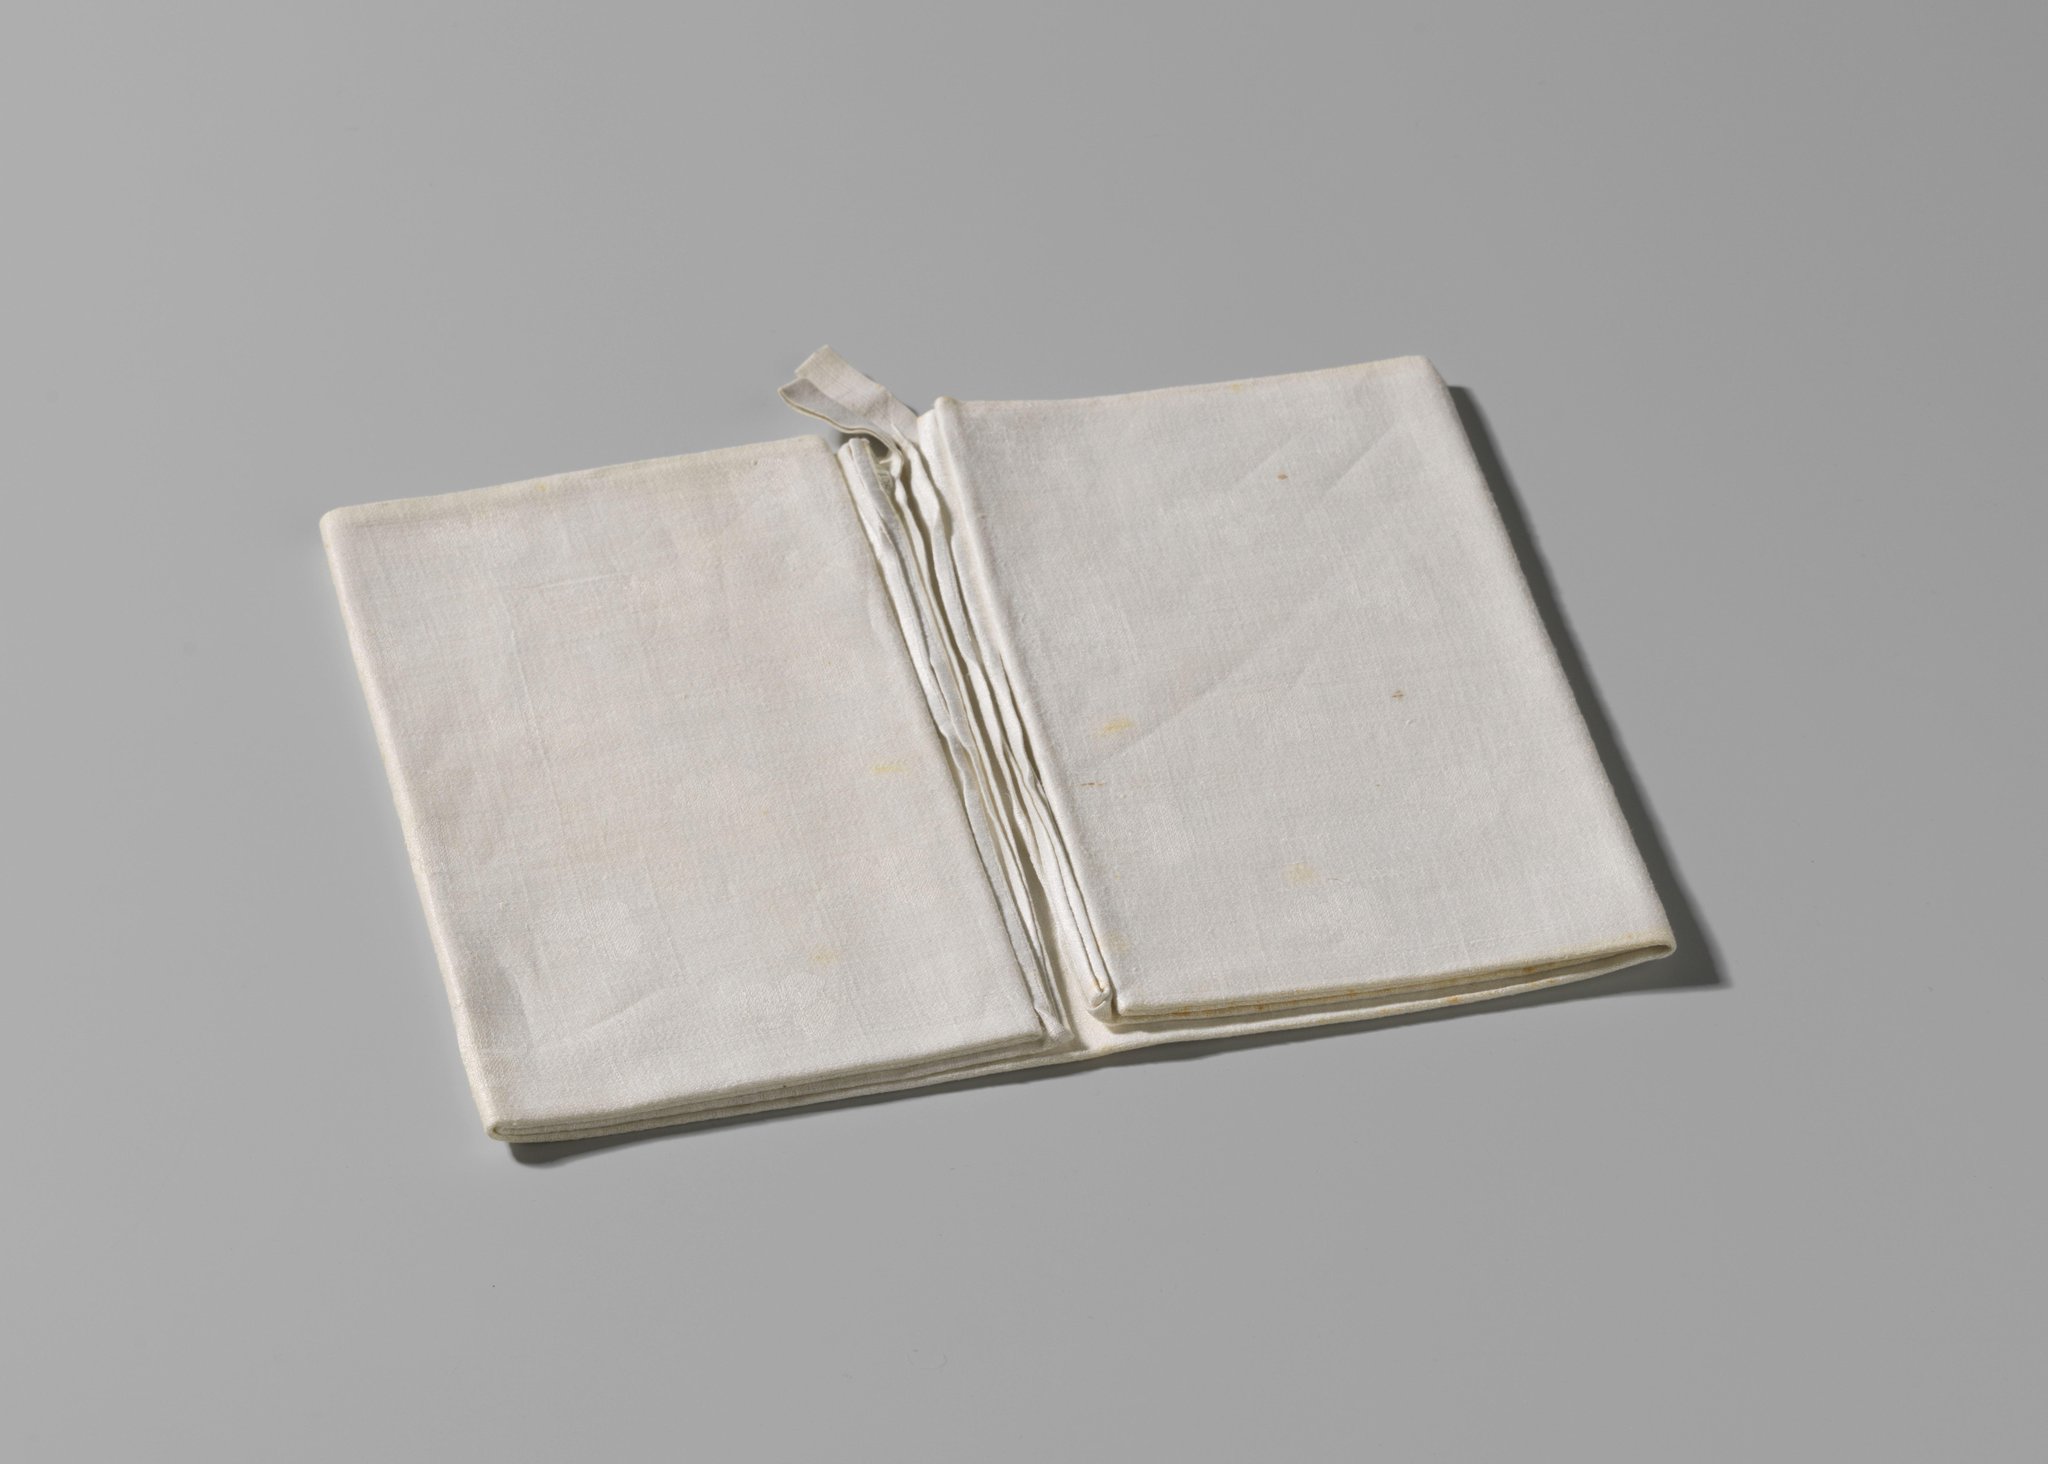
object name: napkin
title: Handdoek of servet van wit linnendamast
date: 1825-1850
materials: linen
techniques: damask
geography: netherlands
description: Wit linnen damasten servet (of handdoek?) met klaverblaadje in verband binnen bloemenrand. Gemerkt B S 60.